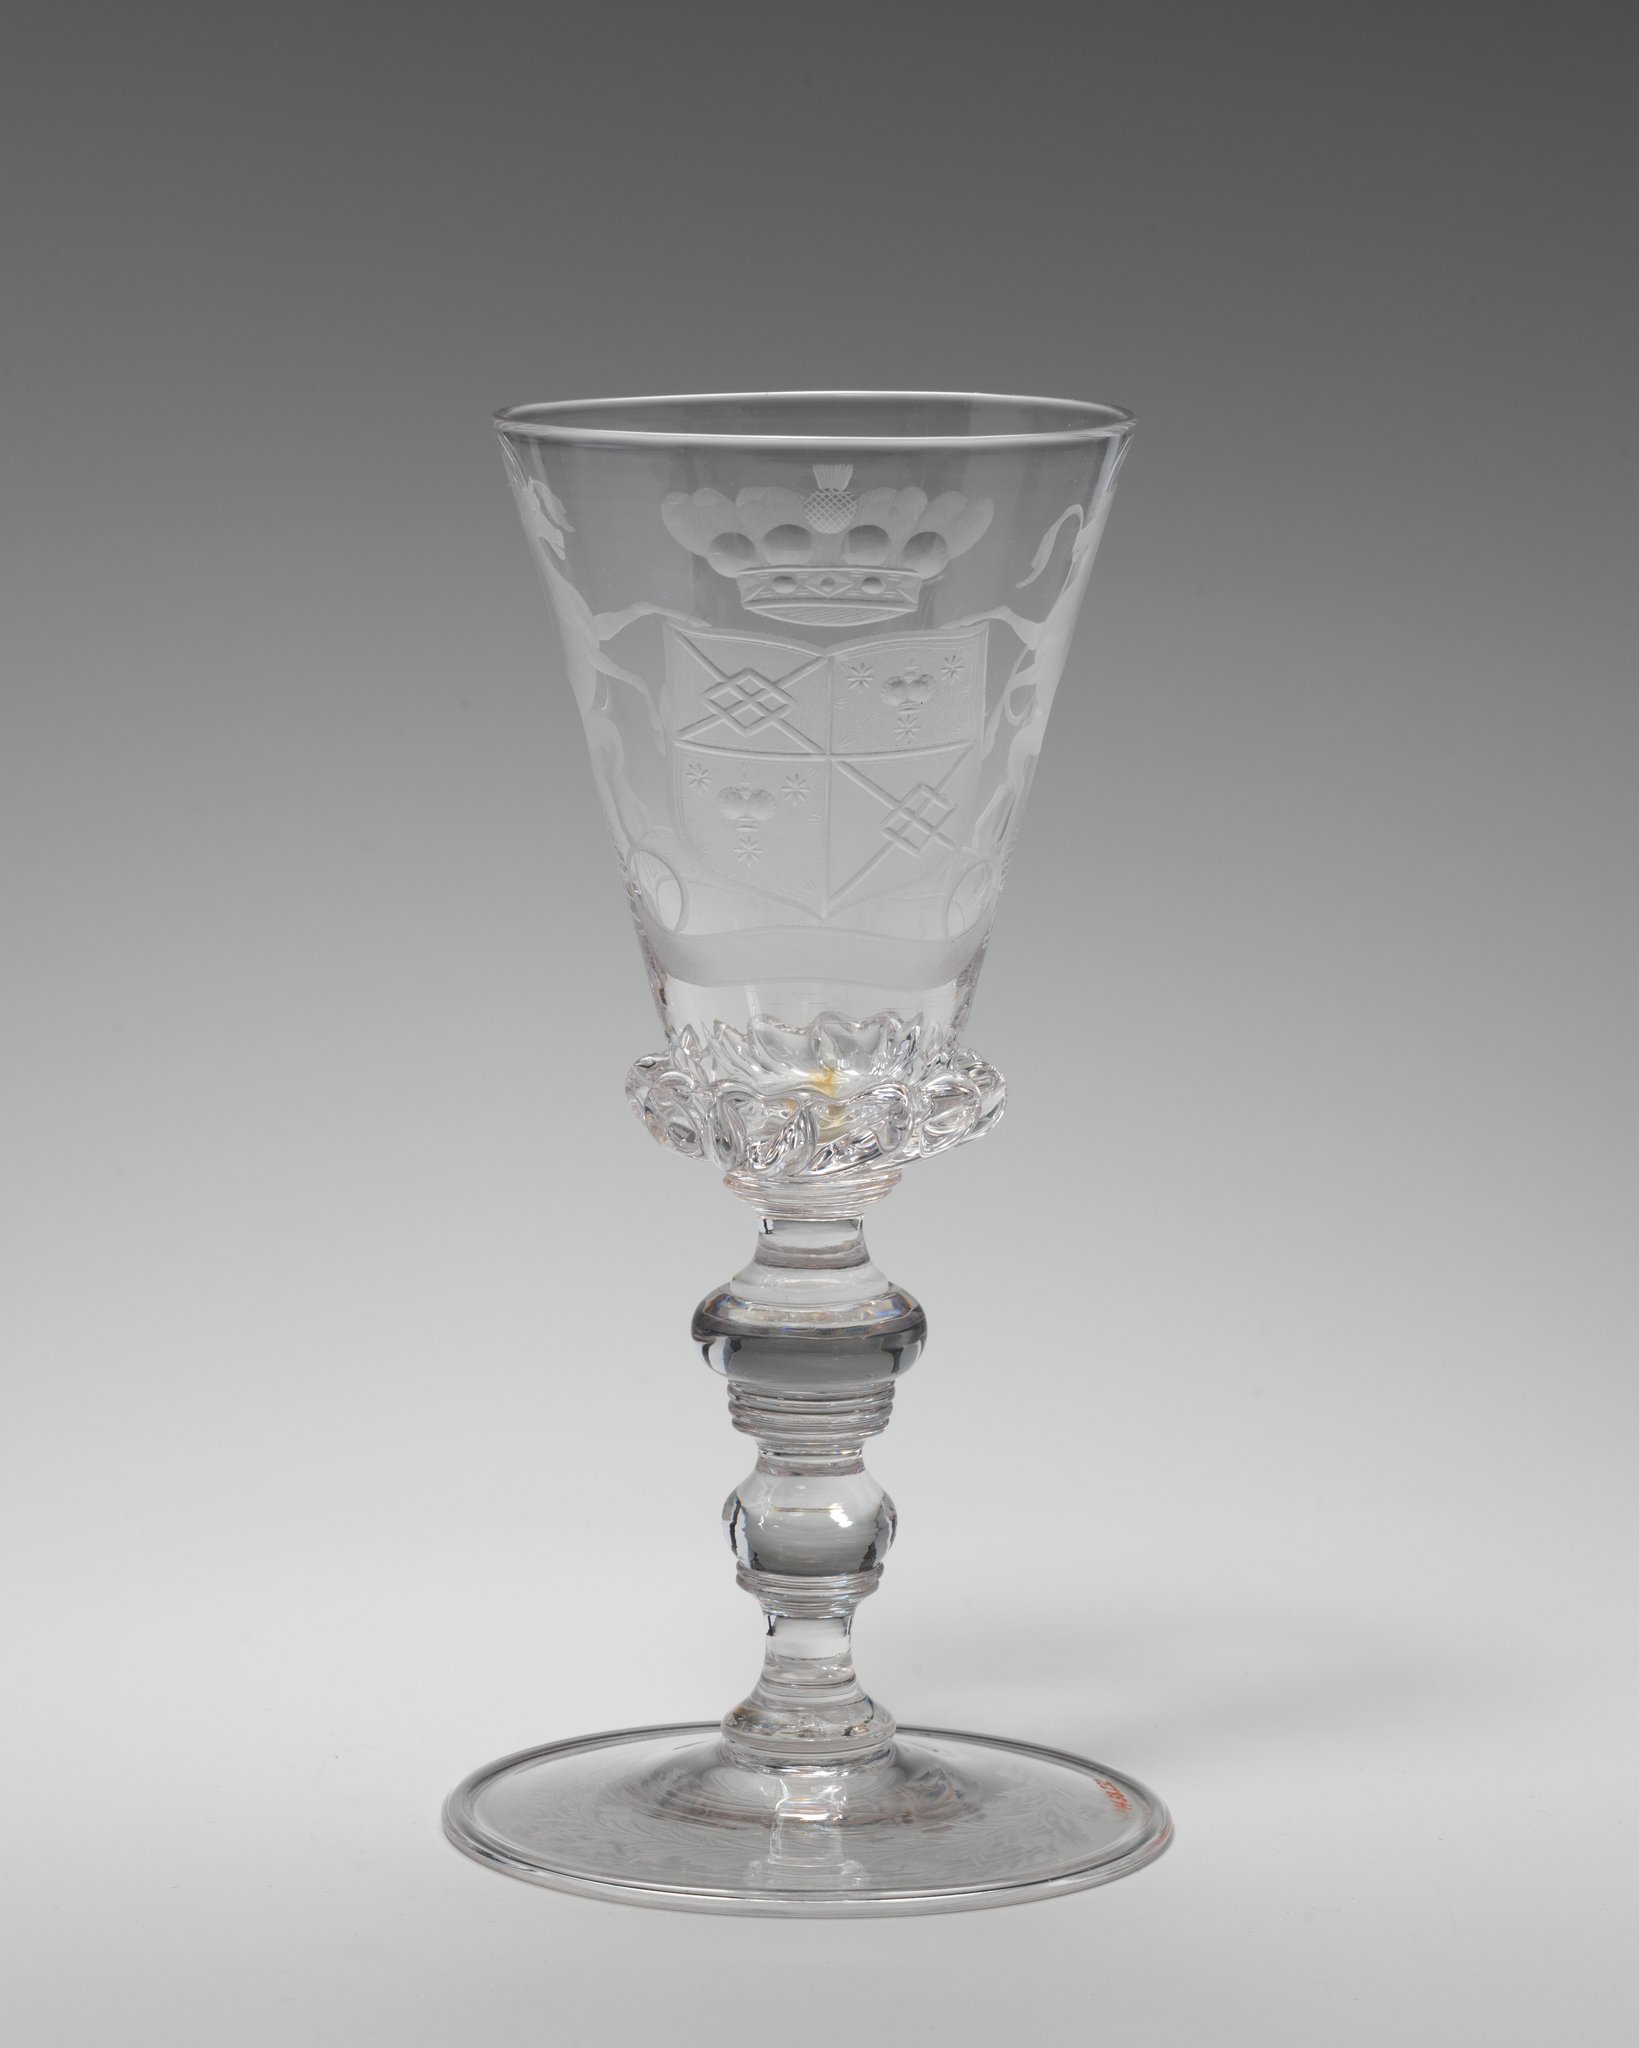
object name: wineglass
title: Wineglass (one of a pair)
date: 1867-1900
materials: glass